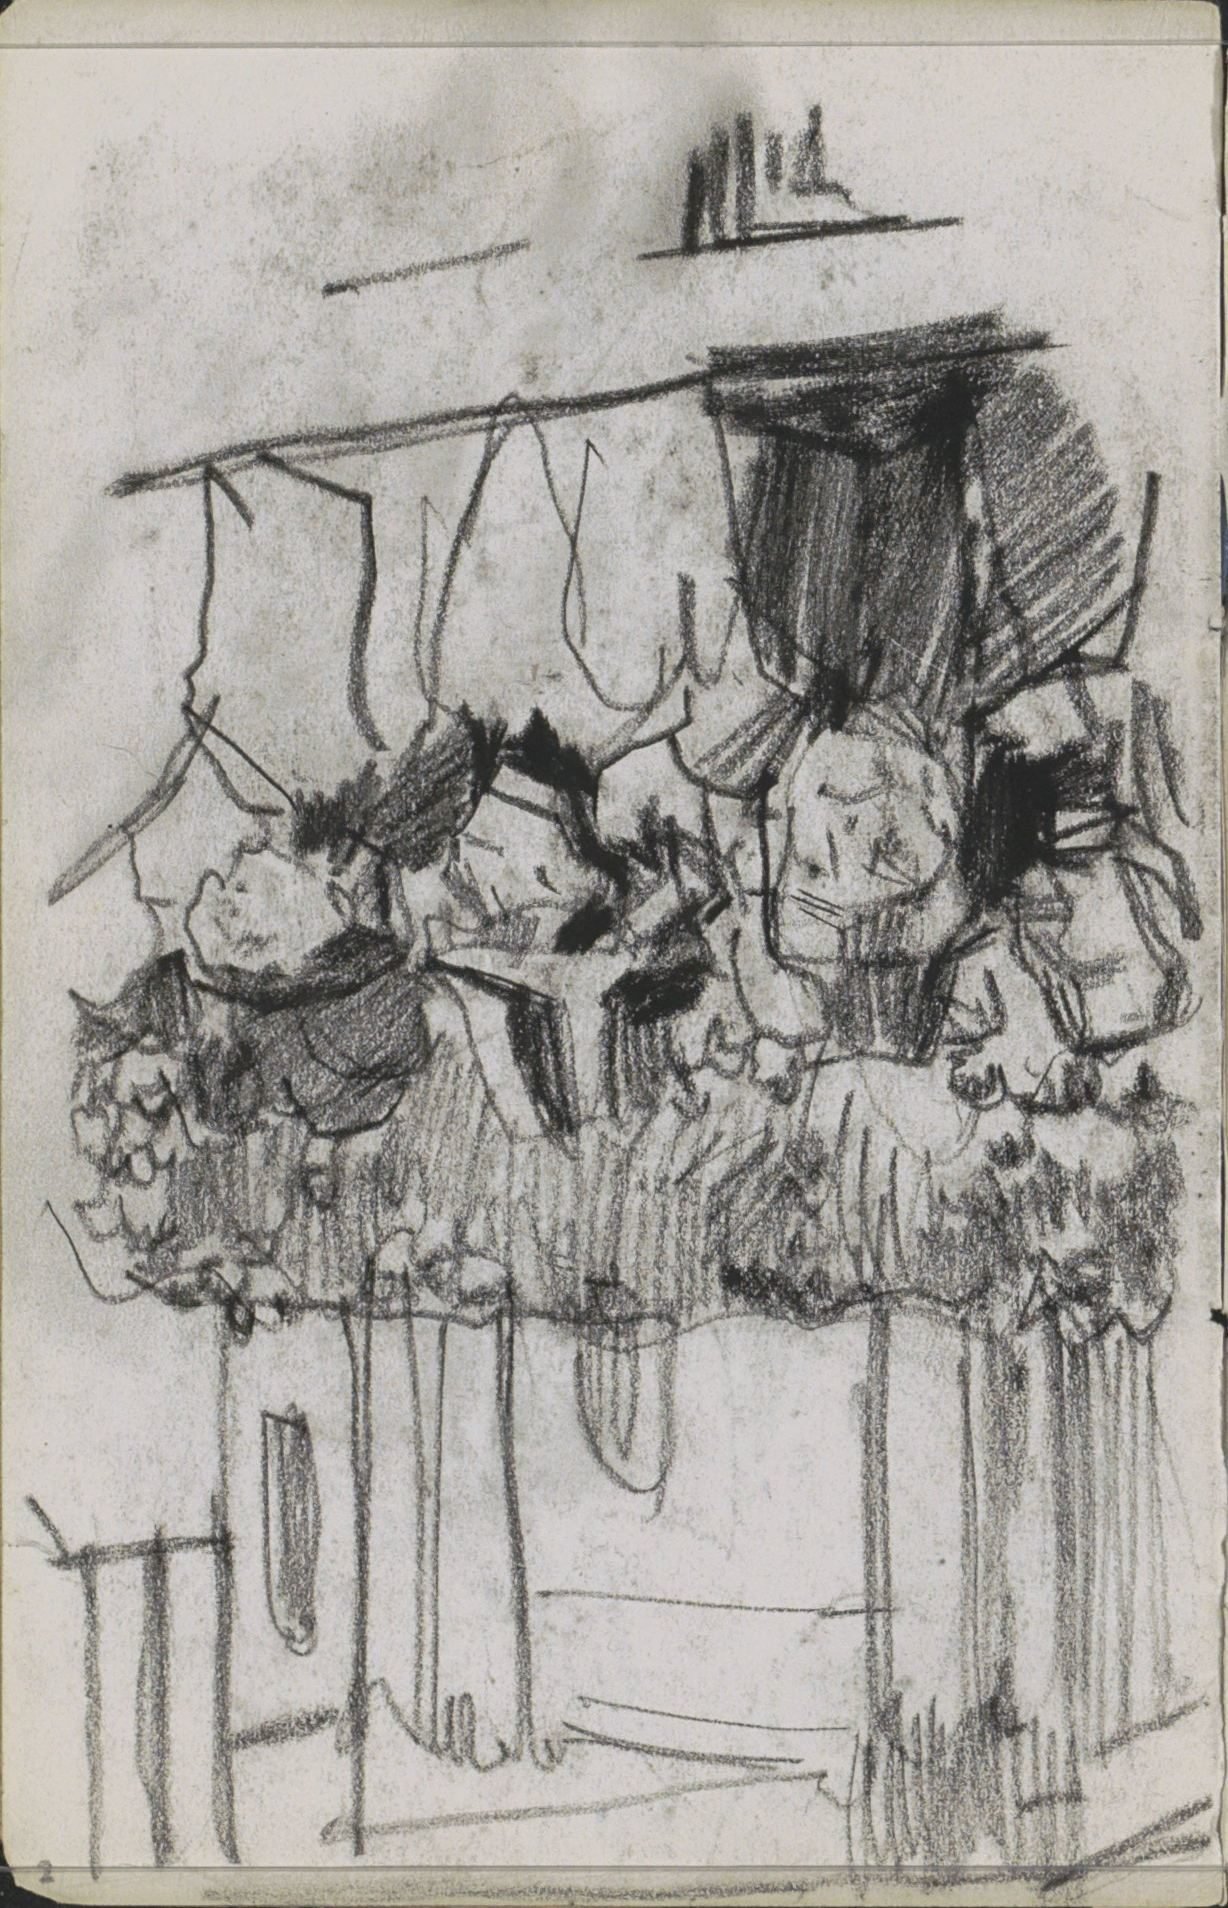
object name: sketchbook leaf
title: Figuren in een kerk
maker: isaac israels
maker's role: draughtsman, painter, print maker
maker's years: 1865-1934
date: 1875-1934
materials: chalk, paper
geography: amsterdam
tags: interior of church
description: Pagina 2 uit schetsboek XXIX met 44 pagina's.